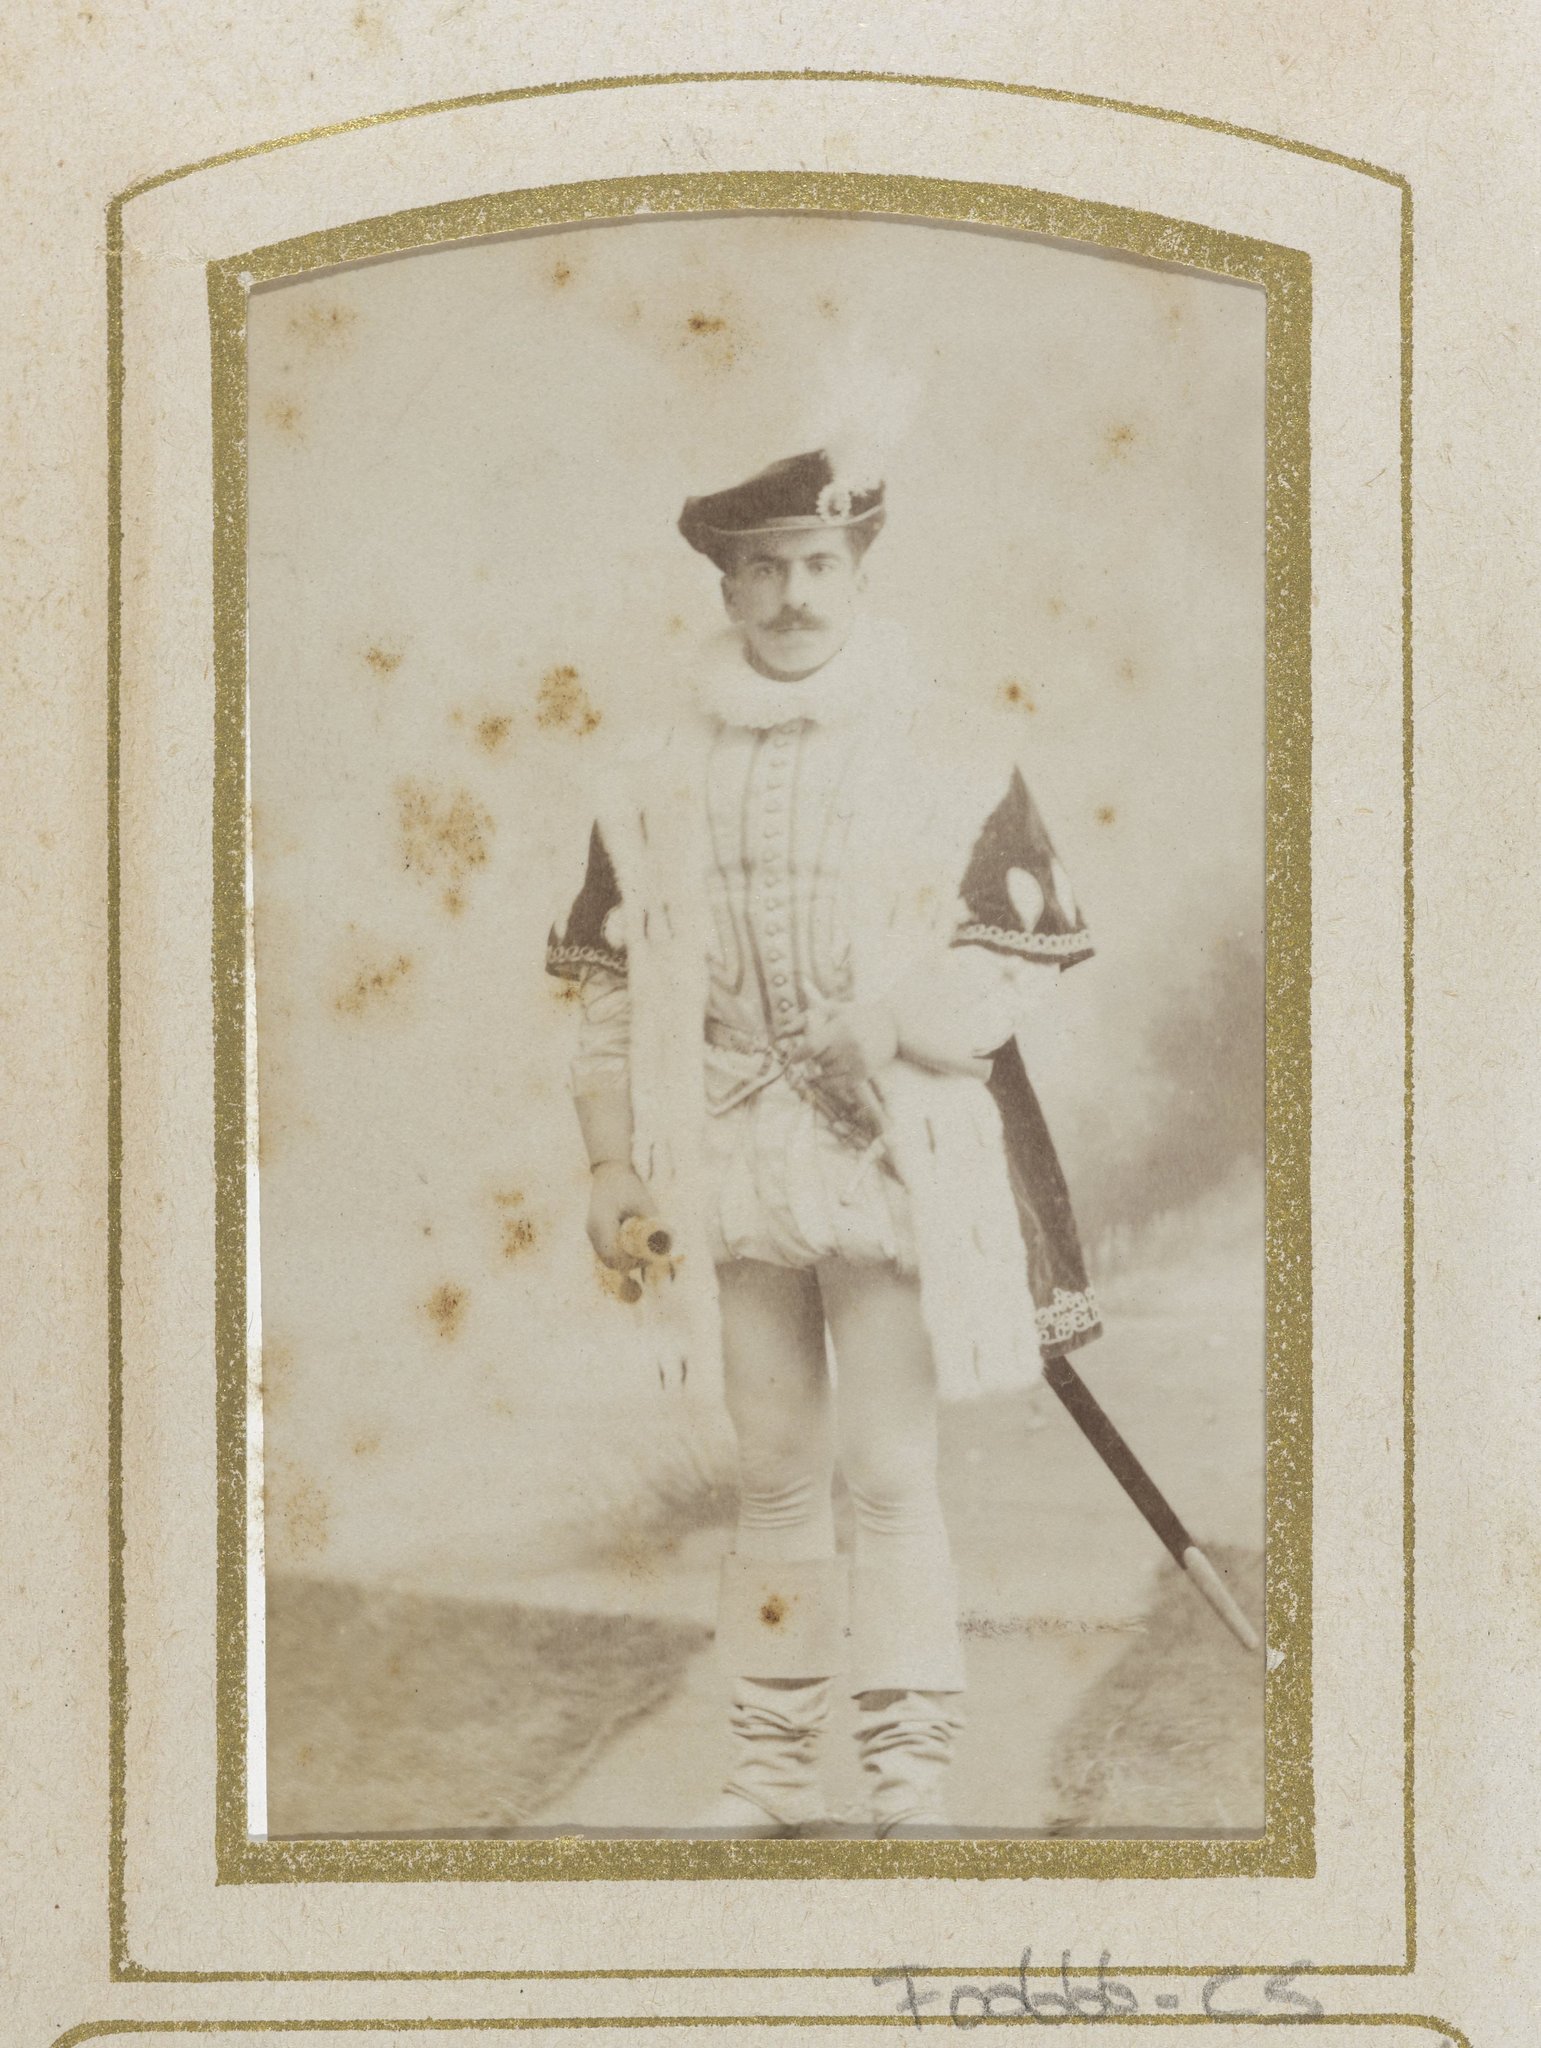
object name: photograph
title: Portret van David François Teixeira de Mattos in kostuum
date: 1884-1894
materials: cardboard, photographic support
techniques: albumen print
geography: amsterdam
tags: historical persons, historical costume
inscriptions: inscription: ‘Photographisch Artistisch Atelier/ van/ Wegner & Mottu/ Rokin over de Bank 138,/ Amsterdam/ Het cliché wordt voor verdere/ bestellingen bewaard.’, name: ‘D. F. Teixeira de Mattos.’